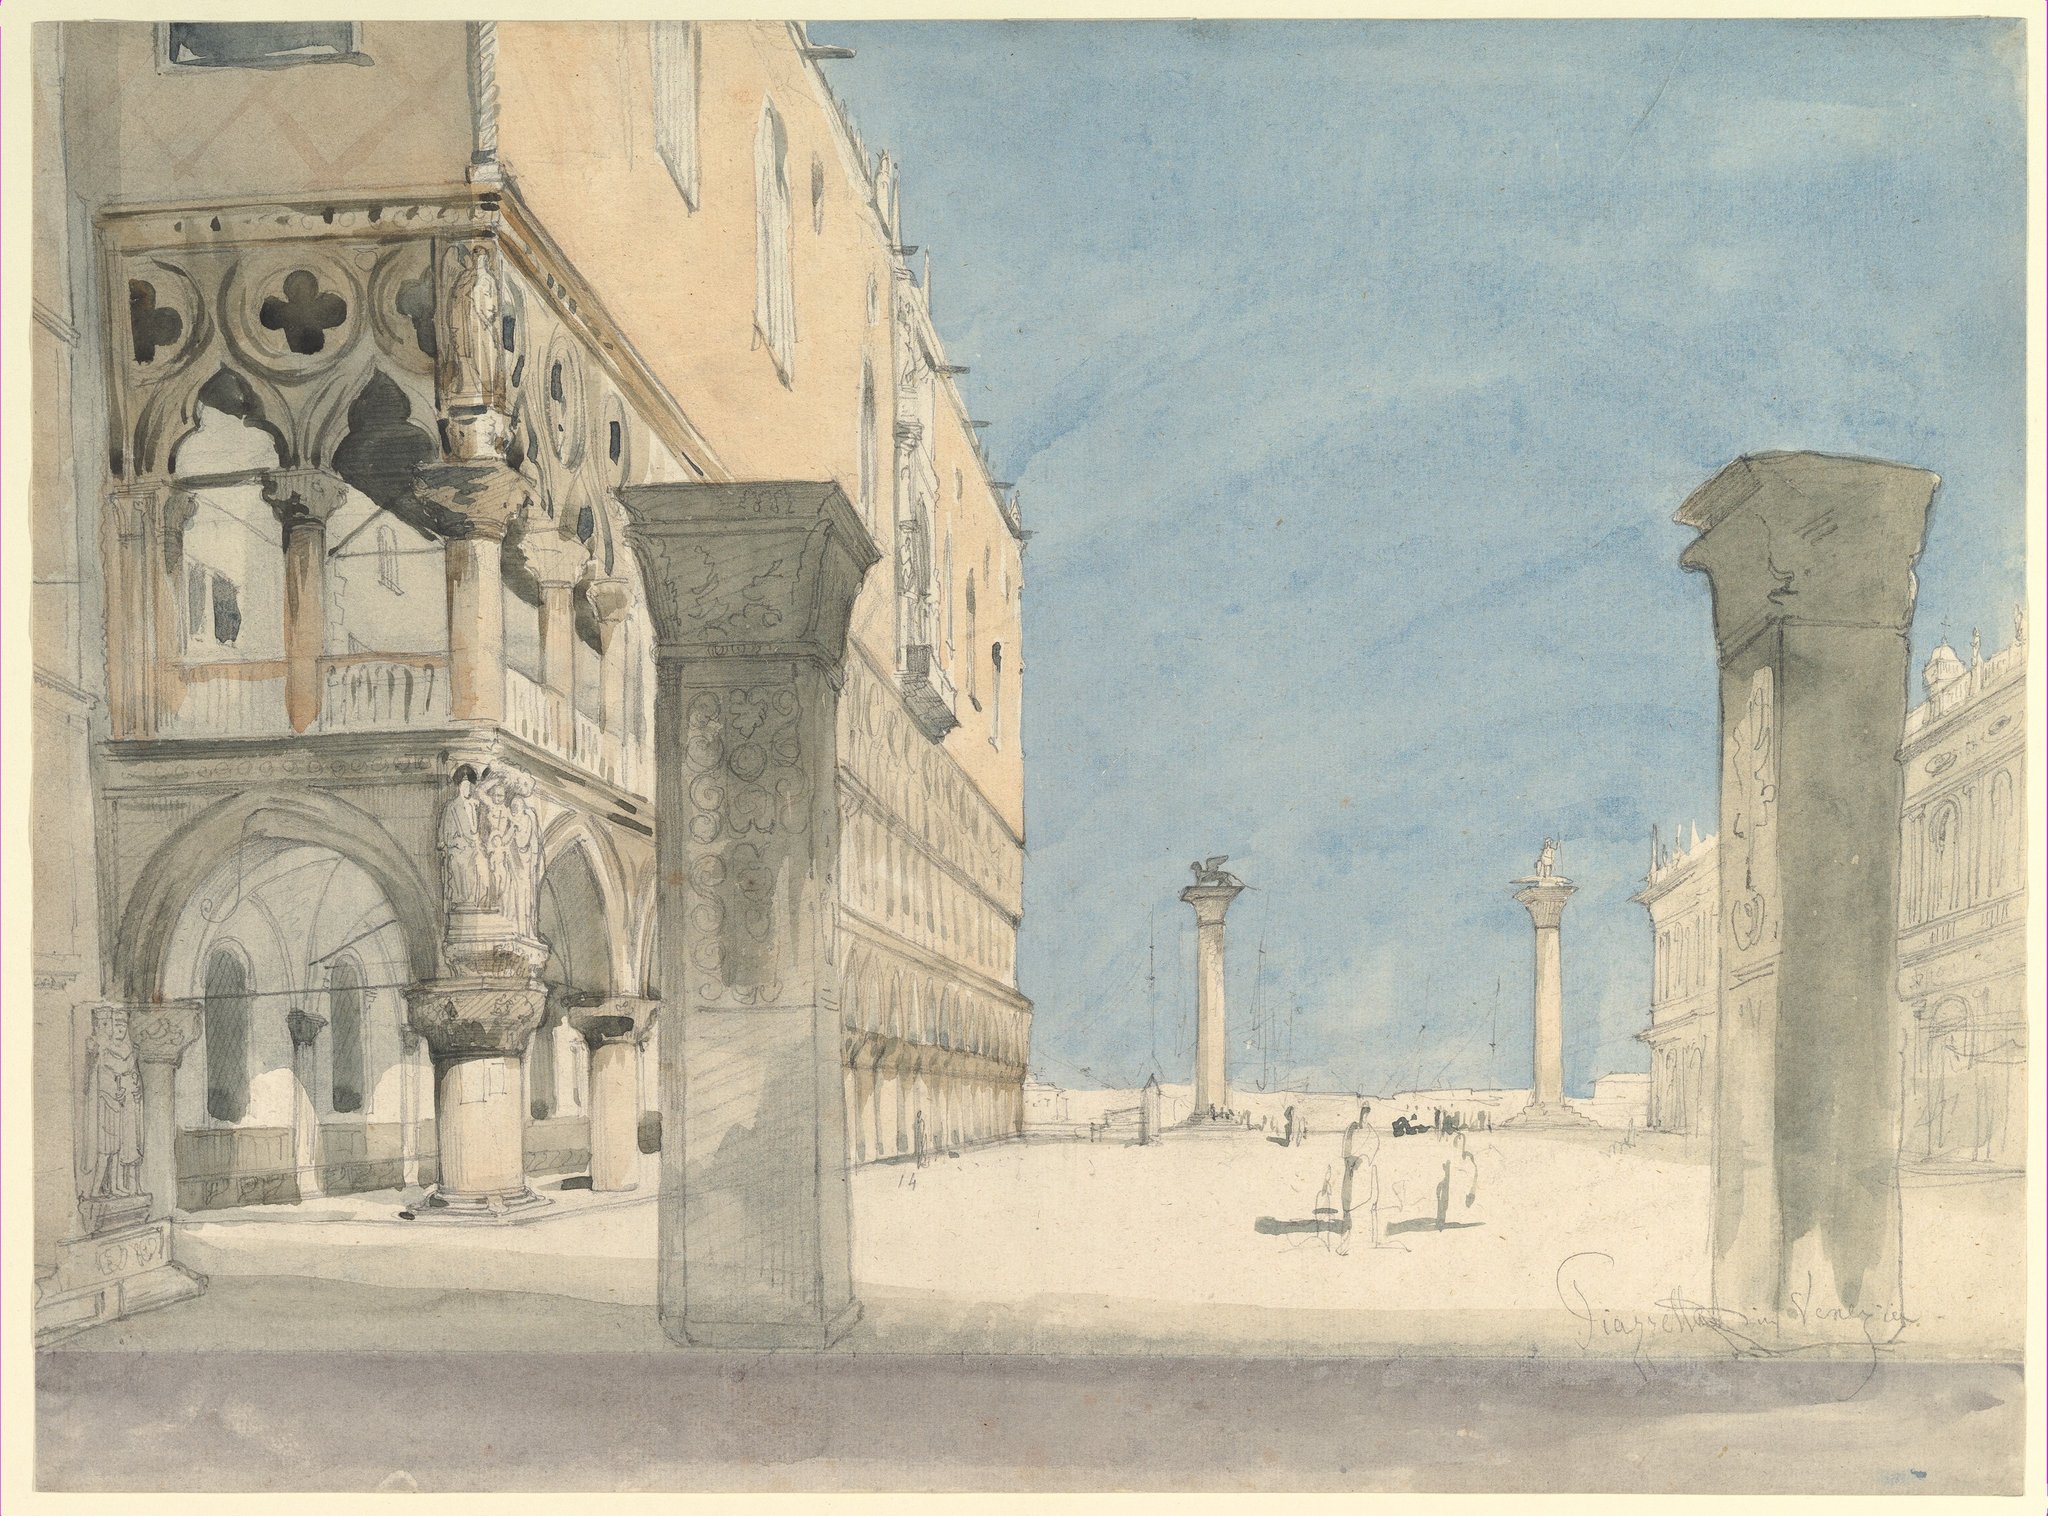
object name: drawing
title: View of the Piazzetta di San Marco in Venice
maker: wilhelm gail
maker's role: artist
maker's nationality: german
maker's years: 1804-1890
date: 1801-1900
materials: graphite, watercolor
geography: germany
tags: architecture,buildings,columns,venice